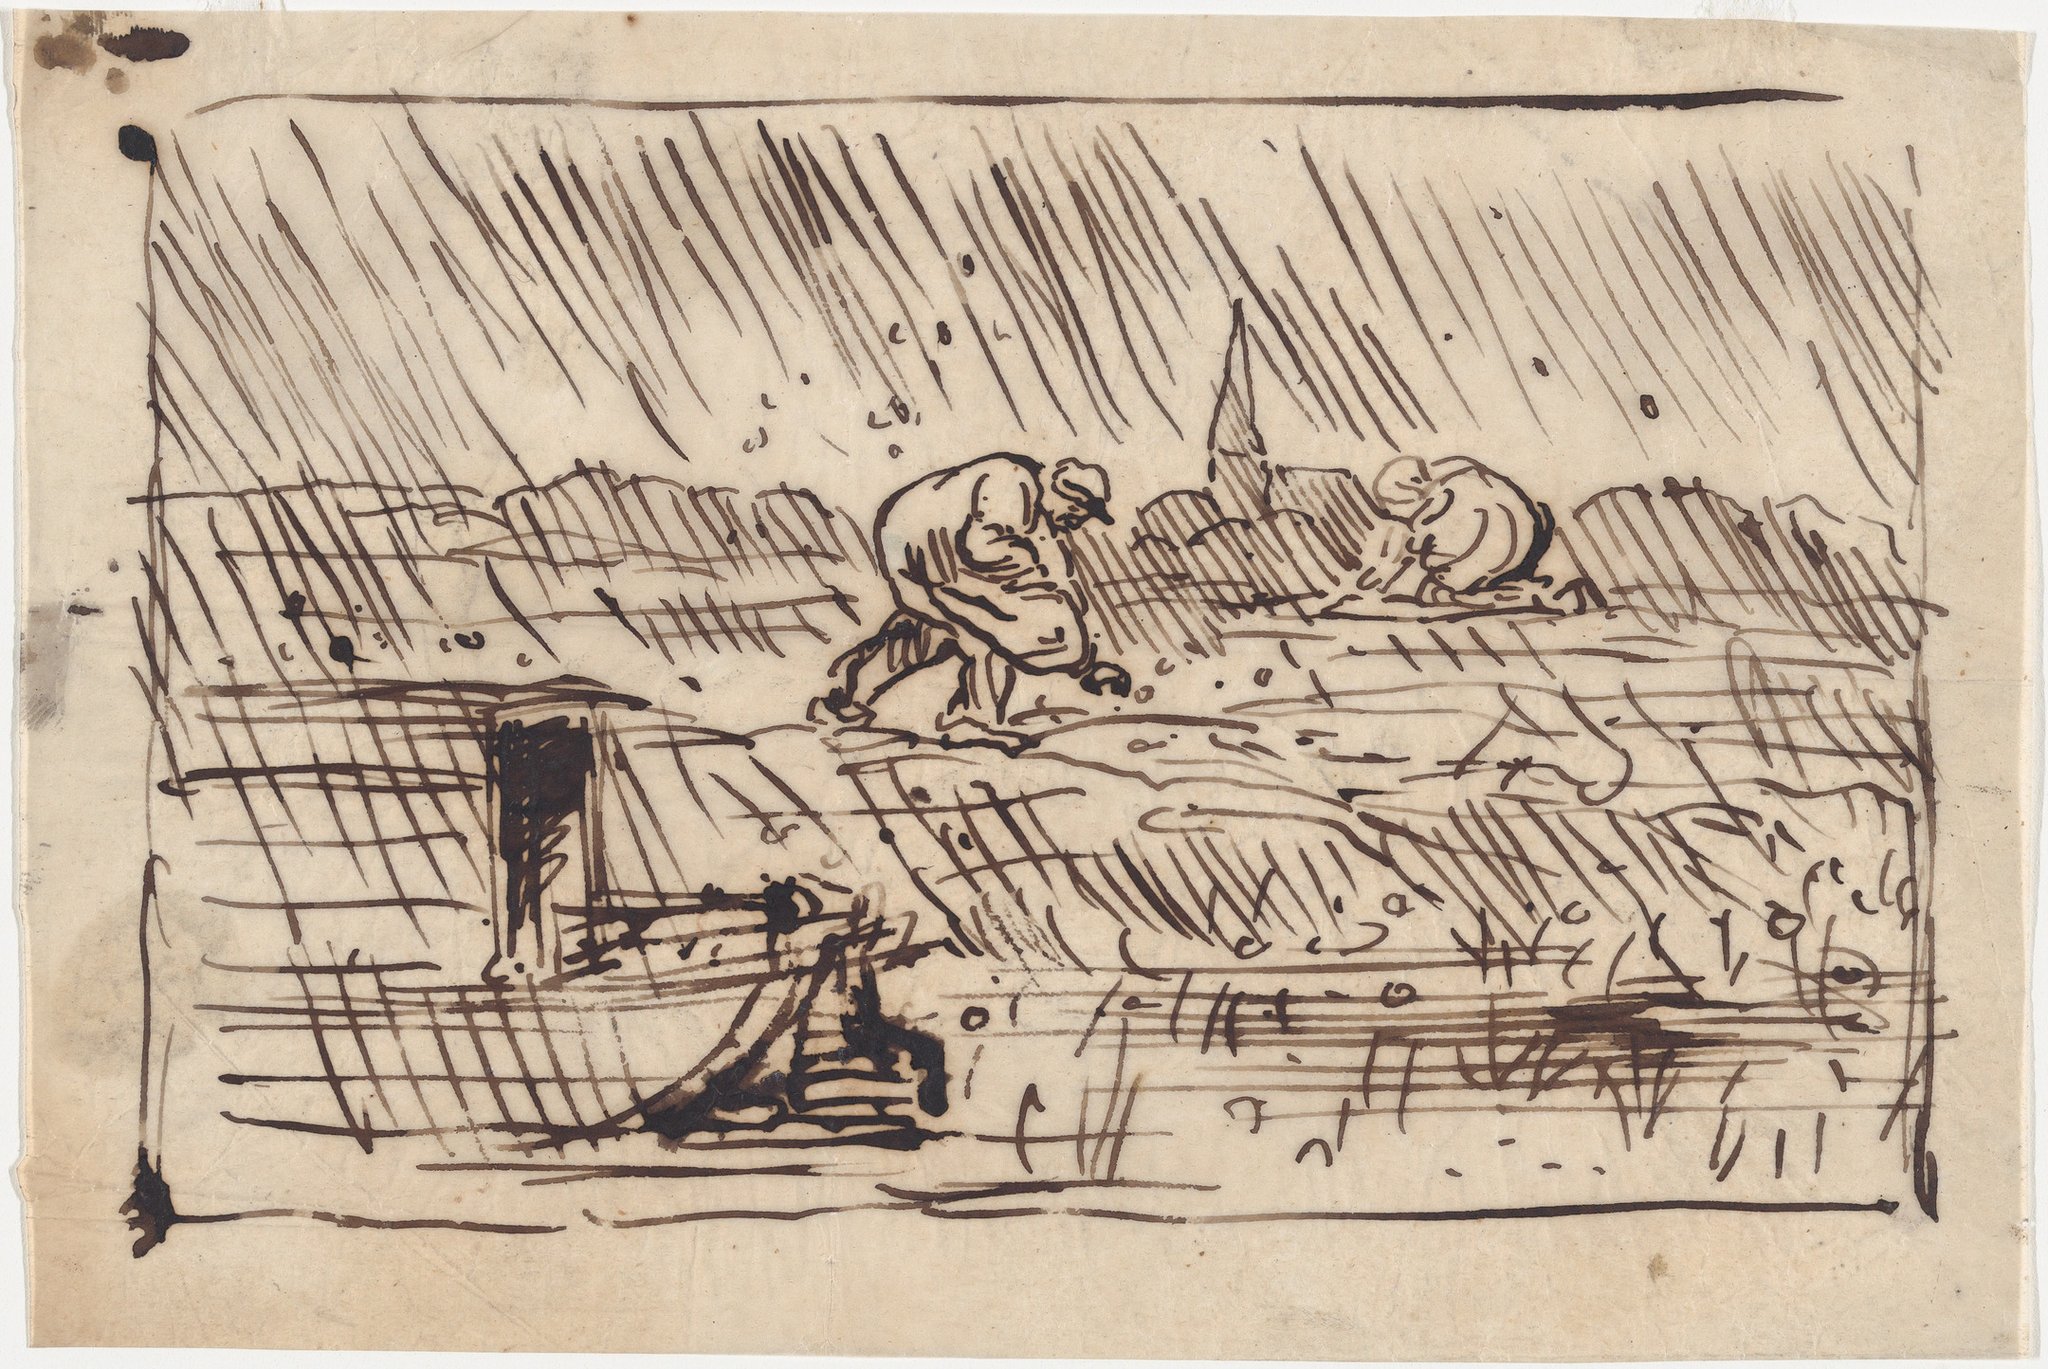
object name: drawing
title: Gleaners in the Hail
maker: charles-françois daubigny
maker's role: artist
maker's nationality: french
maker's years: 1817-1878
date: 1862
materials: ink, paper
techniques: pen